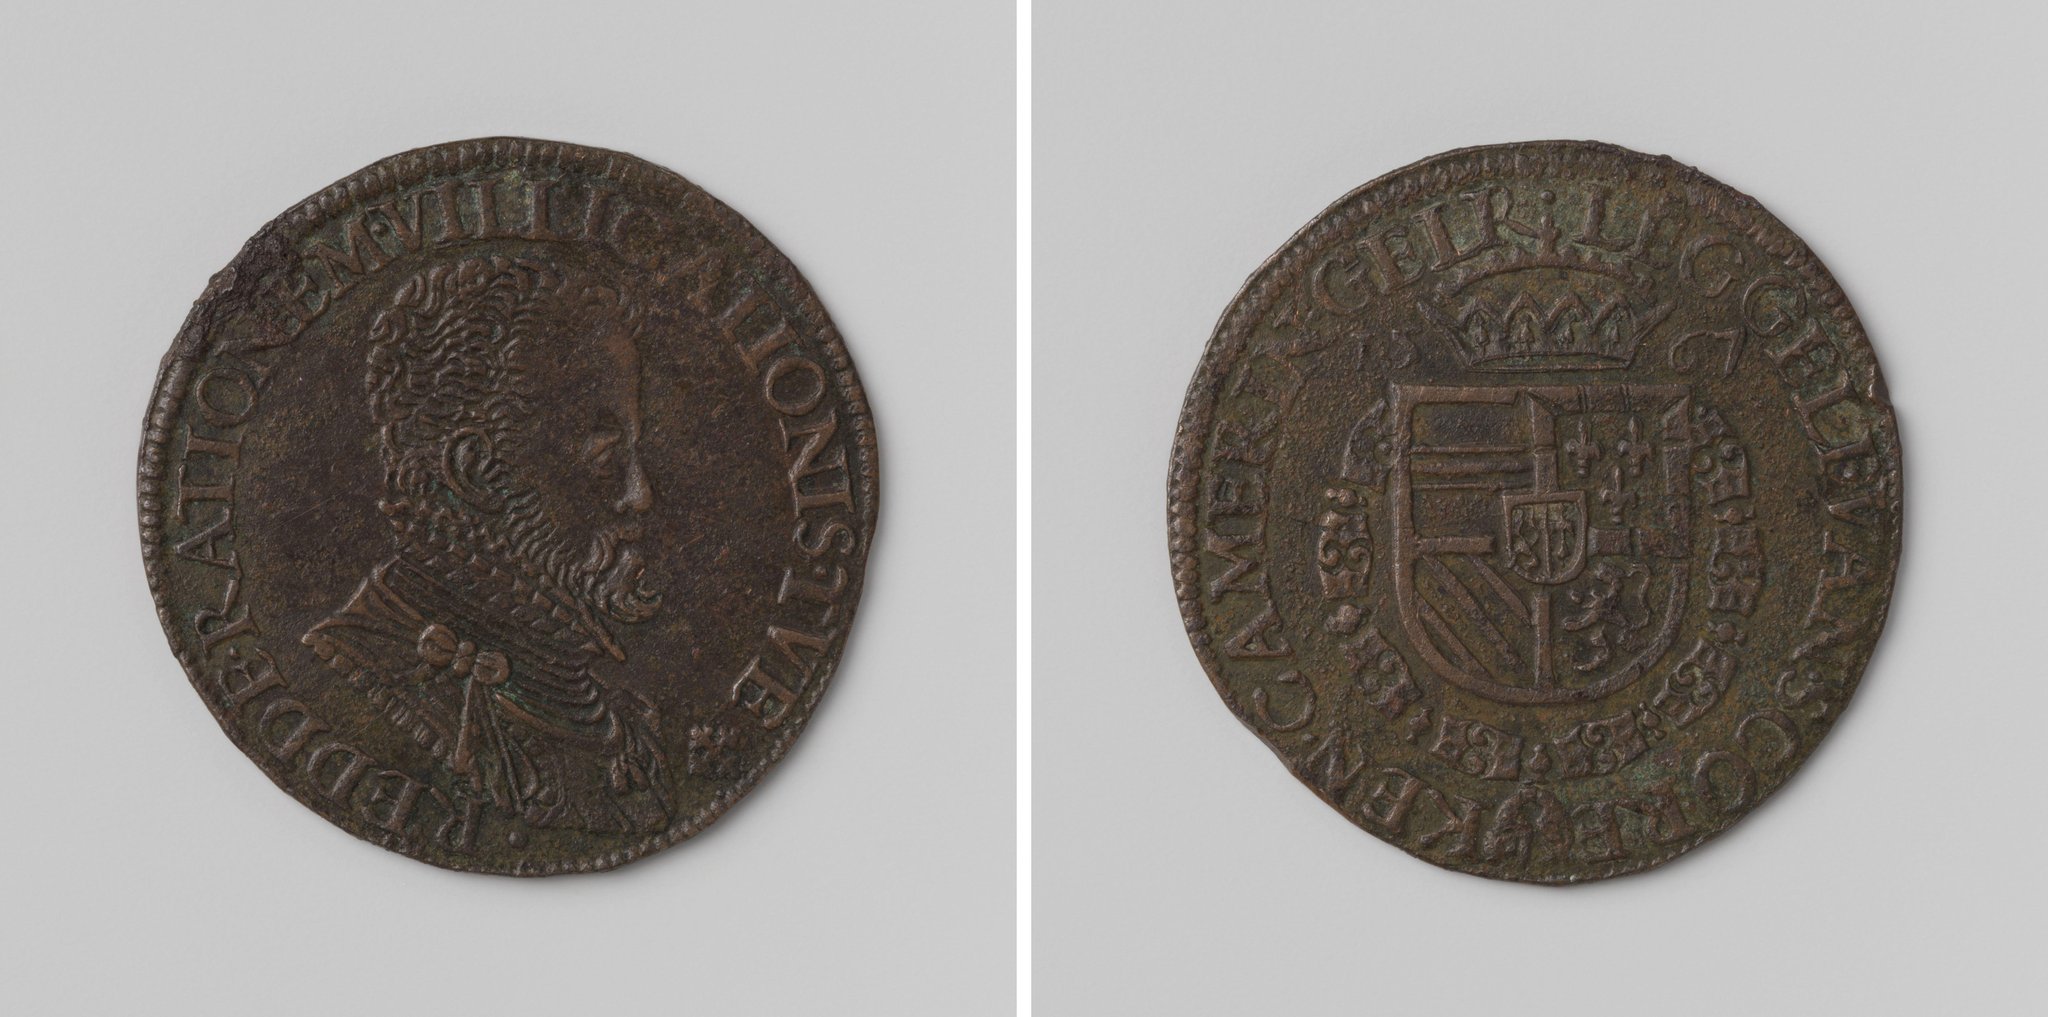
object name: jeton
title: Filips II, koning van Spanje, rekenpenning van de rekenkamer van Gelderland te Arnhem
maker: Anonymous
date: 1567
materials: copper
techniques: striking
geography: netherlands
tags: philip ii of spain, arnhem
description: Koperen penning. Voorzijde: borststuk man binnen omschrift. Keerzijde: gekroond wapenschild omhangen met orde van Gulden Vlies tussen jaartal binnen omschrift